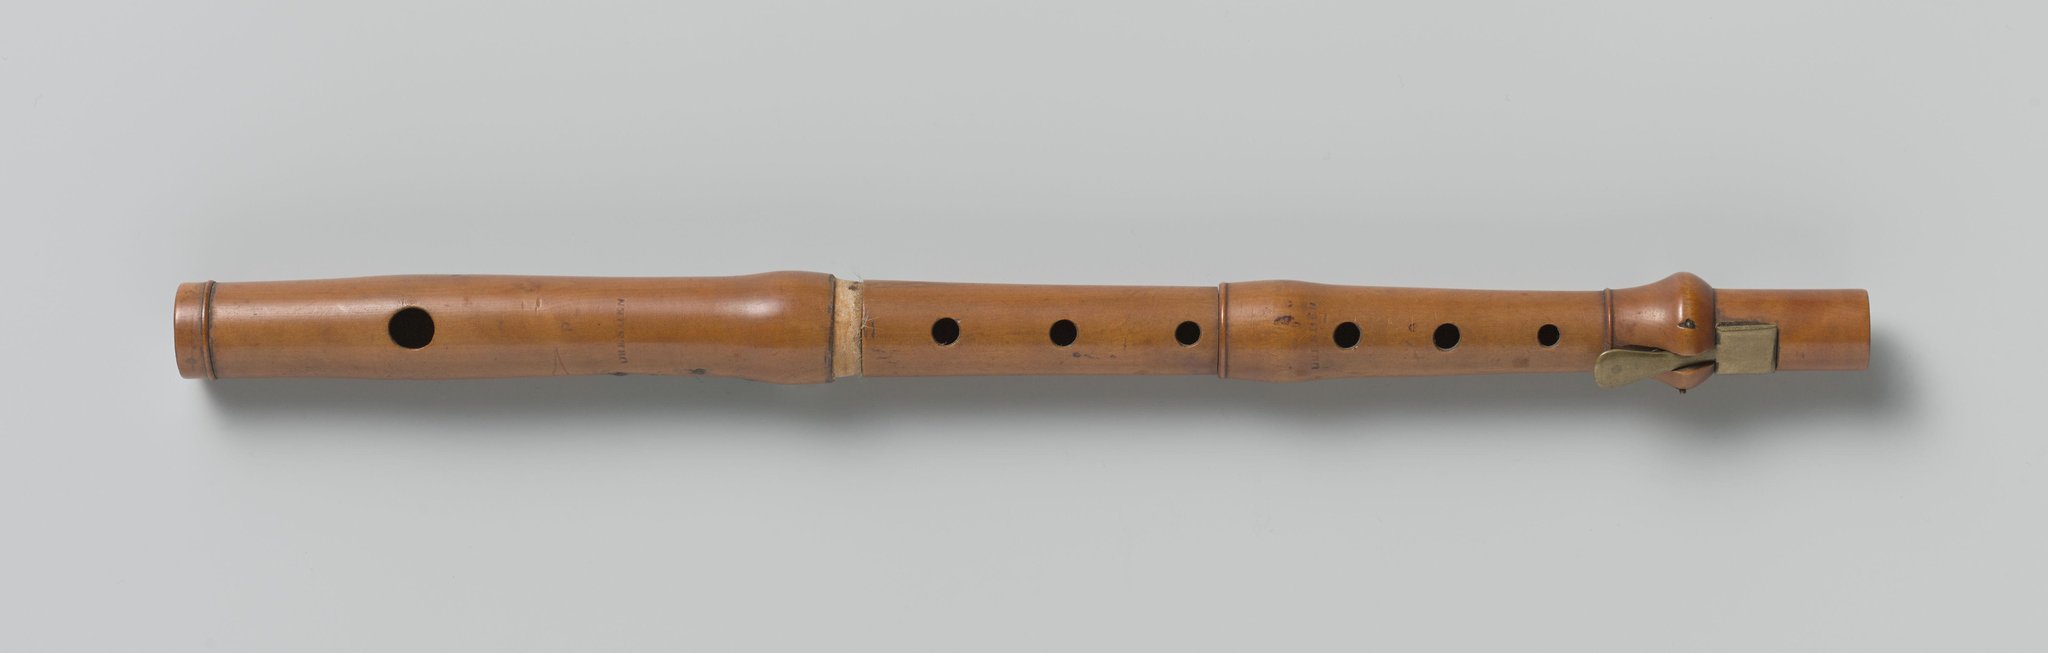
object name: wind instrument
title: Piccolo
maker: Anonymous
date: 1800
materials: wood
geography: dresden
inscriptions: stamp: ‘[...]/ Dresden’, stamp: ‘Dresden’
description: Piccolo van palmhout met een klep. Bovenstuk.